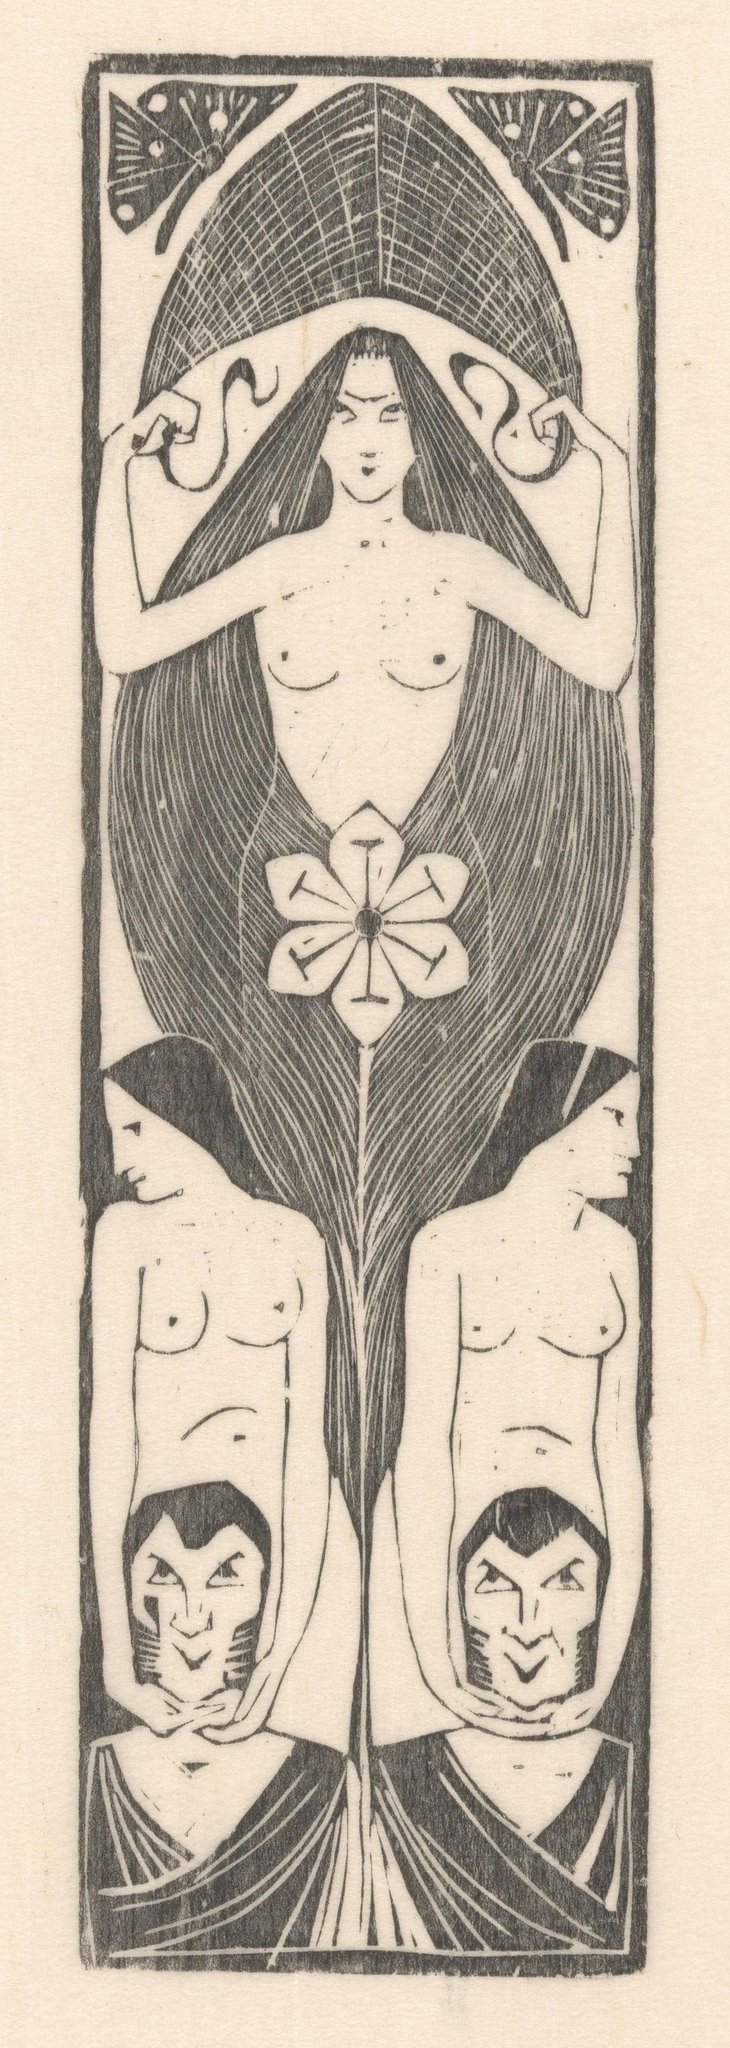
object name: print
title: Naakte vrouw boven twee naakte vrouwen en twee geklede mannen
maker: karel petrus cornelis de bazel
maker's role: draughtsman, print maker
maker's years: 1869-1923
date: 1894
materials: paper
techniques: woodcut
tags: flowers, woman (showing herself) undressed, quasi-nude, insects: butterfly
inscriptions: collector's mark: Lugt 2228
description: Een symmetrische compositie met een vrouw met ontbloot bovenlijf, van wie het onderlichaam door haar hoofdhaar aan het zicht onttrokken wordt. Voor haar kruis een bloem. Links- en rechtsboven een vlinder. Links- en rechtsonder een staande, naakte vrouw, die het hoofd van een geklede man met beide handen vasthoudt.